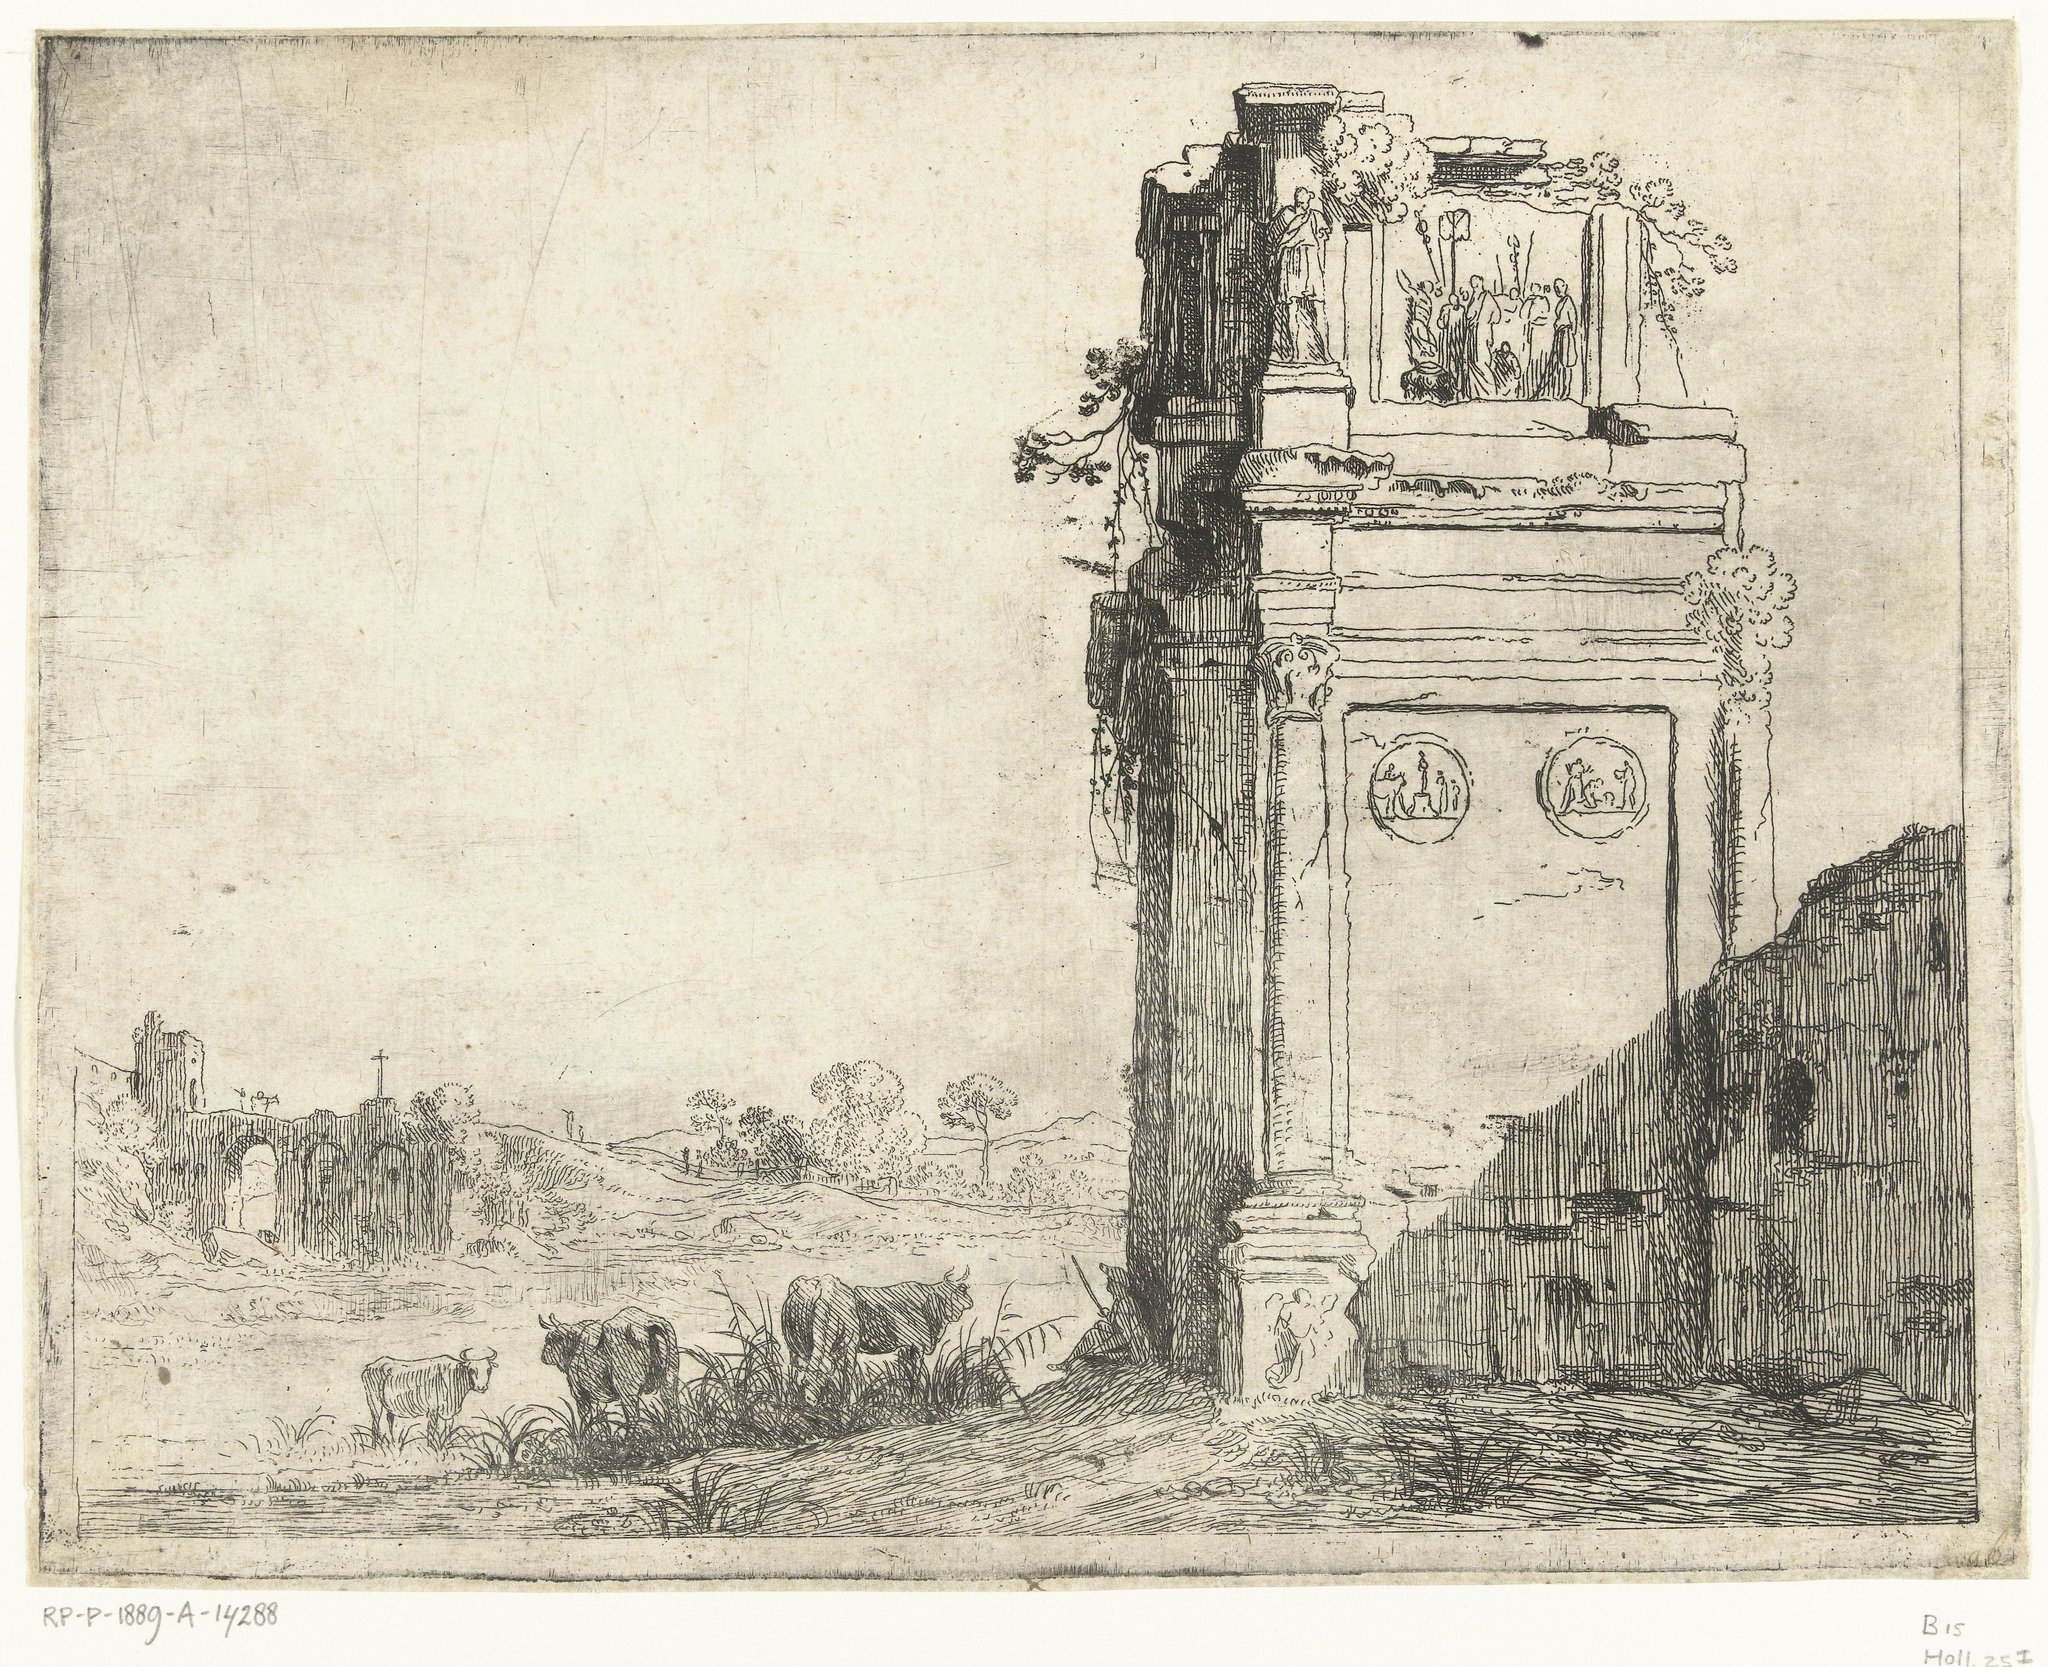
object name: print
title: Ruïne van Boog van Constantijn te Rome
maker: jan gerritsz. van bronckhorst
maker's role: draughtsman, painter, print maker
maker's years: 1603-1661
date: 1613-1661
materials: paper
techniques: etching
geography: netherlands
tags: ruin of a building ~ architecture, landscape with ruins, arch of constantine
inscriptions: collector's mark: Lugt 2228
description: Prent naar ontwerp van Cornelis van Poelenburch. Prent uit serie van negen prenten met Romeinse ruïnes.